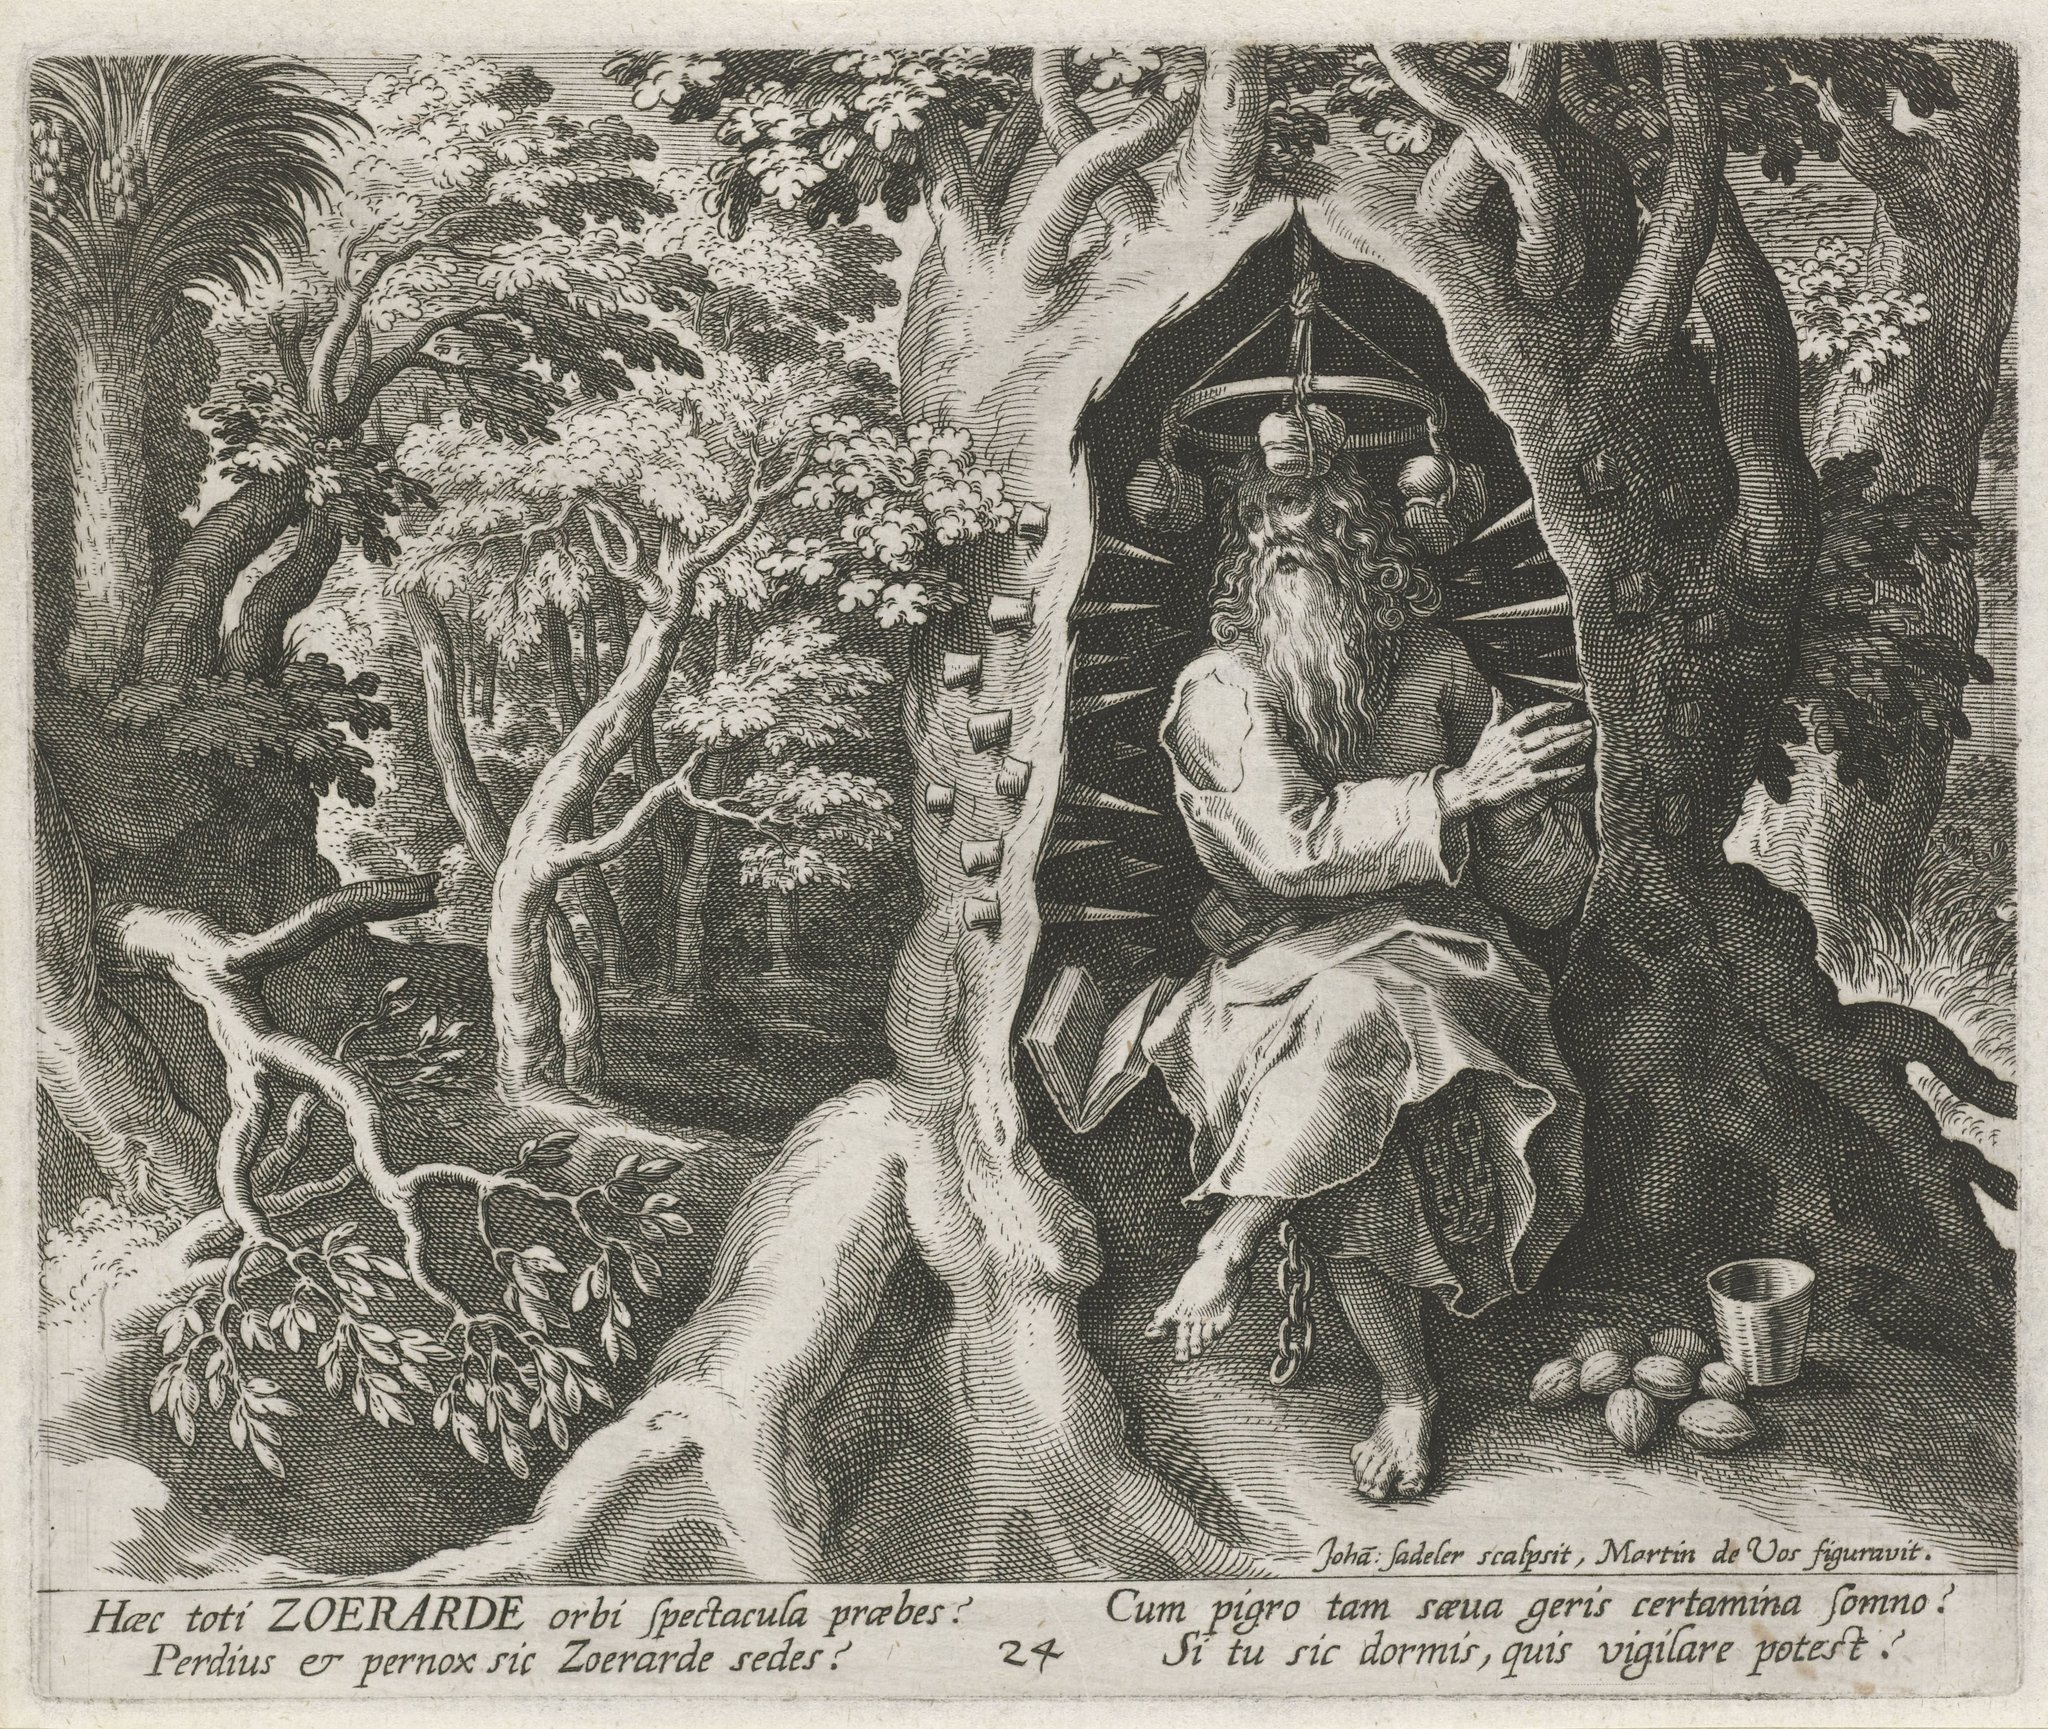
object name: print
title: Heilige Andreas Zoërardus als kluizenaar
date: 1594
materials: paper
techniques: engraving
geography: munich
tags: male saints (with name), trees, self-castigation ~ ascetic life, forest, wood, anchorite, hermit, fruits: walnut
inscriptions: collector's mark: Lugt 240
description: De H. Andreas Zoërardus, een Poolse kluizenaar uit de elfde eeuw na Christus. Hij zit geketend in een holte van een boom. De wand van de boomholte bestaat uit scherpe pieken. Naast hem op de grond enkele noten.